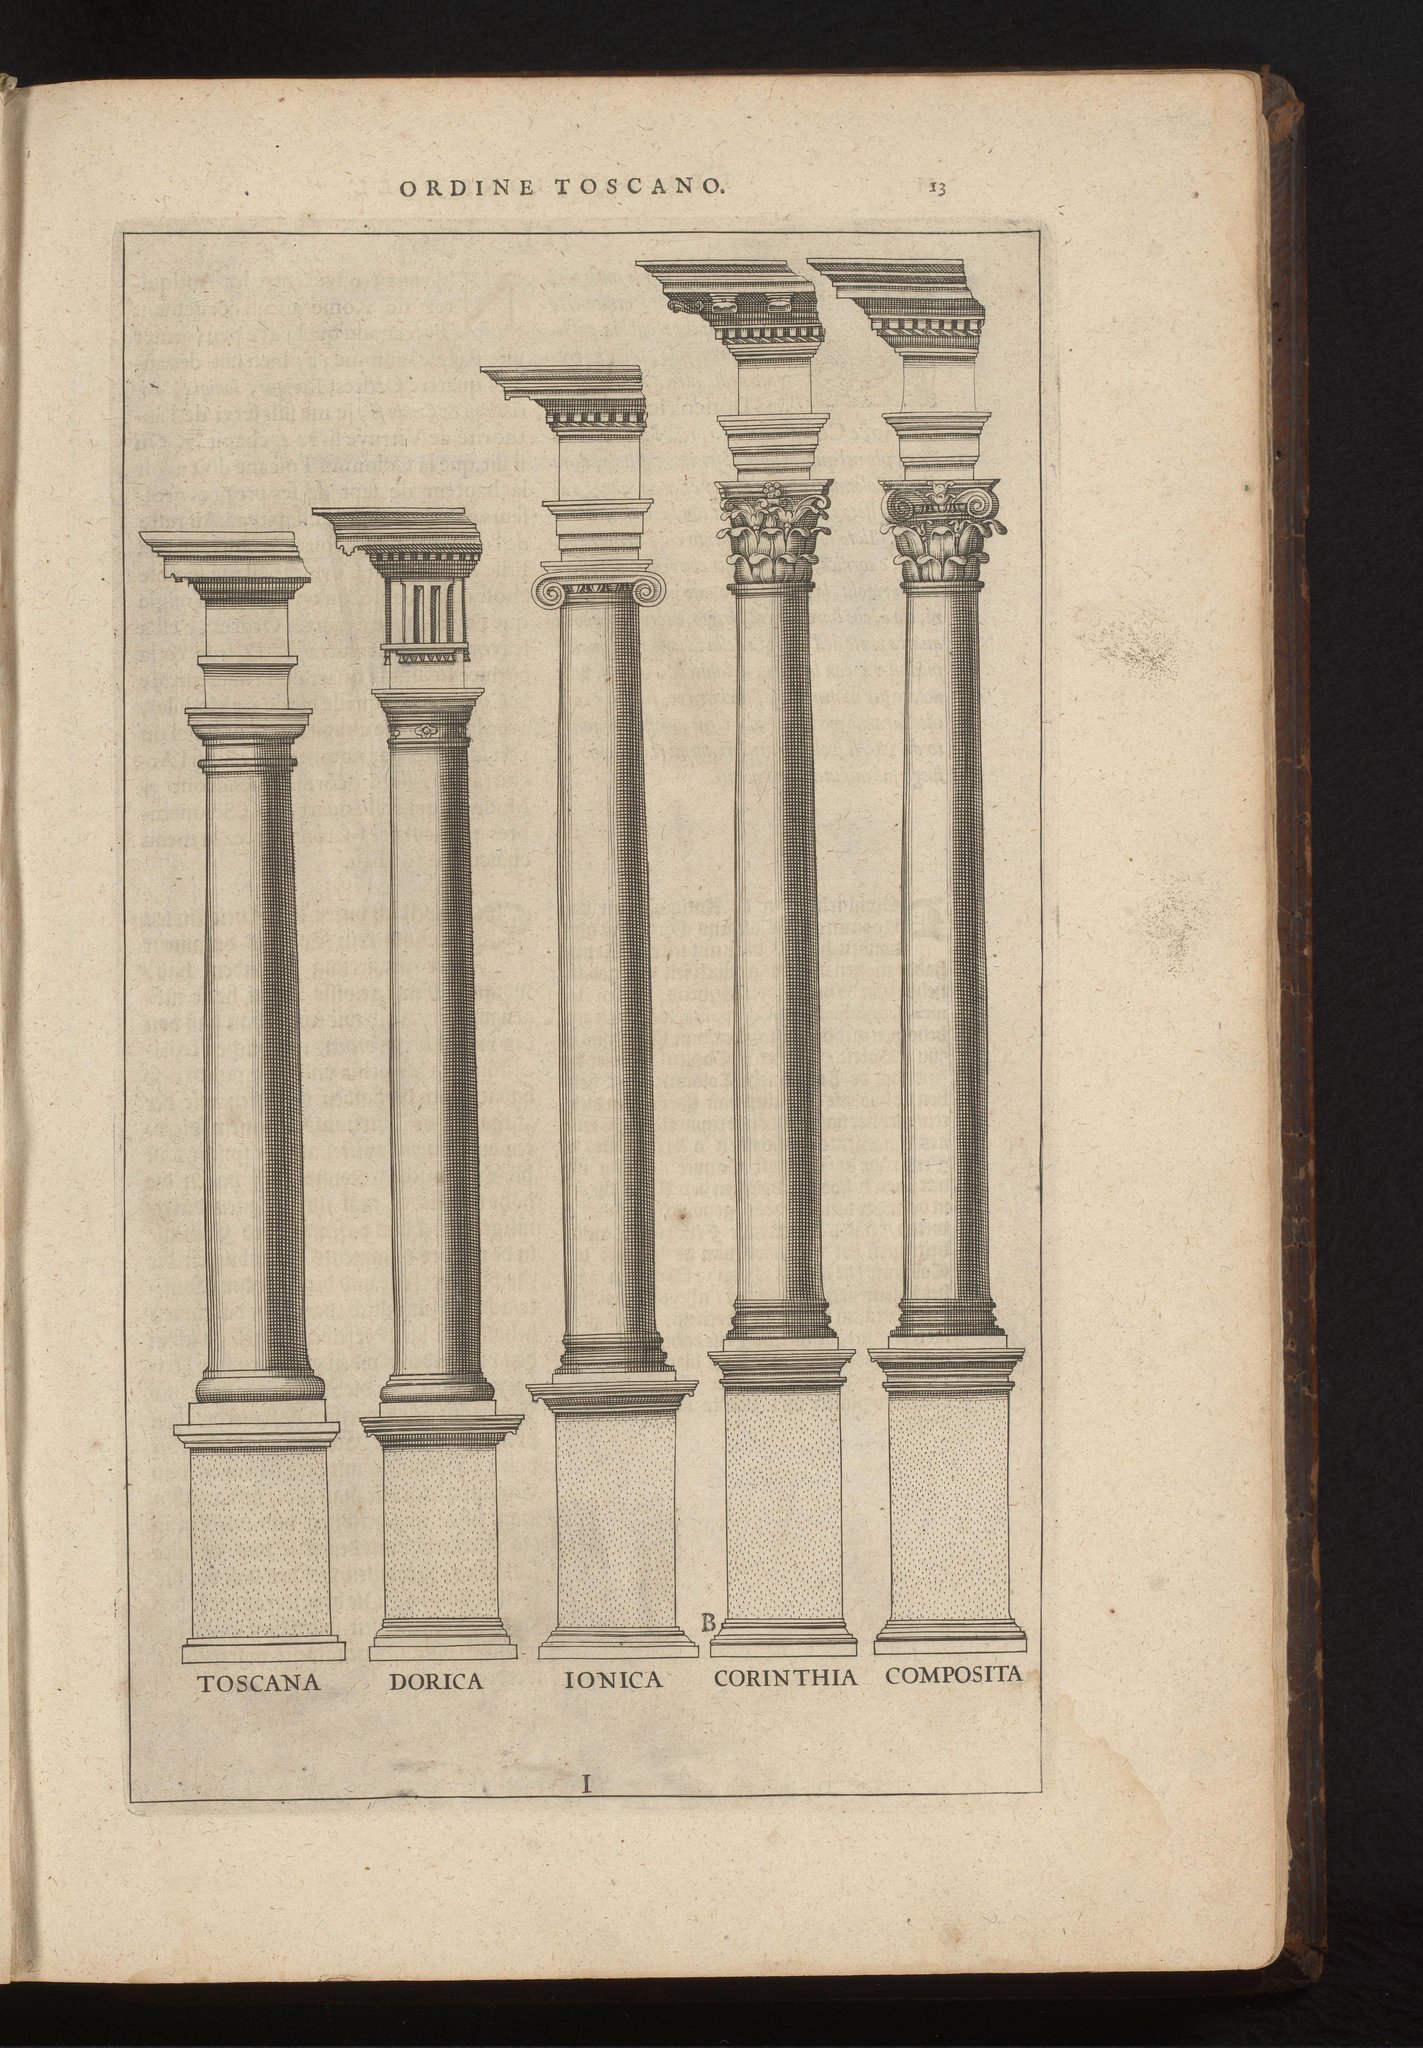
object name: book illustration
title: De vijf bouworden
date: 1640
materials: paper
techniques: engraving, letterpress printing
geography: amsterdam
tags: composite order ~ architecture, doric order ~ architecture, tuscan order ~ architecture, orders, order-books ~ architecture, ionic order ~ architecture, corinthian order ~ architecture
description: Prent uit: Vignola, Giacomo Barozzi da. Regola delli cinque ordini d'architettura (...). Amsterdam: Johannes Willemszoon en Cornelis Blaeu, 1640, p. 13.